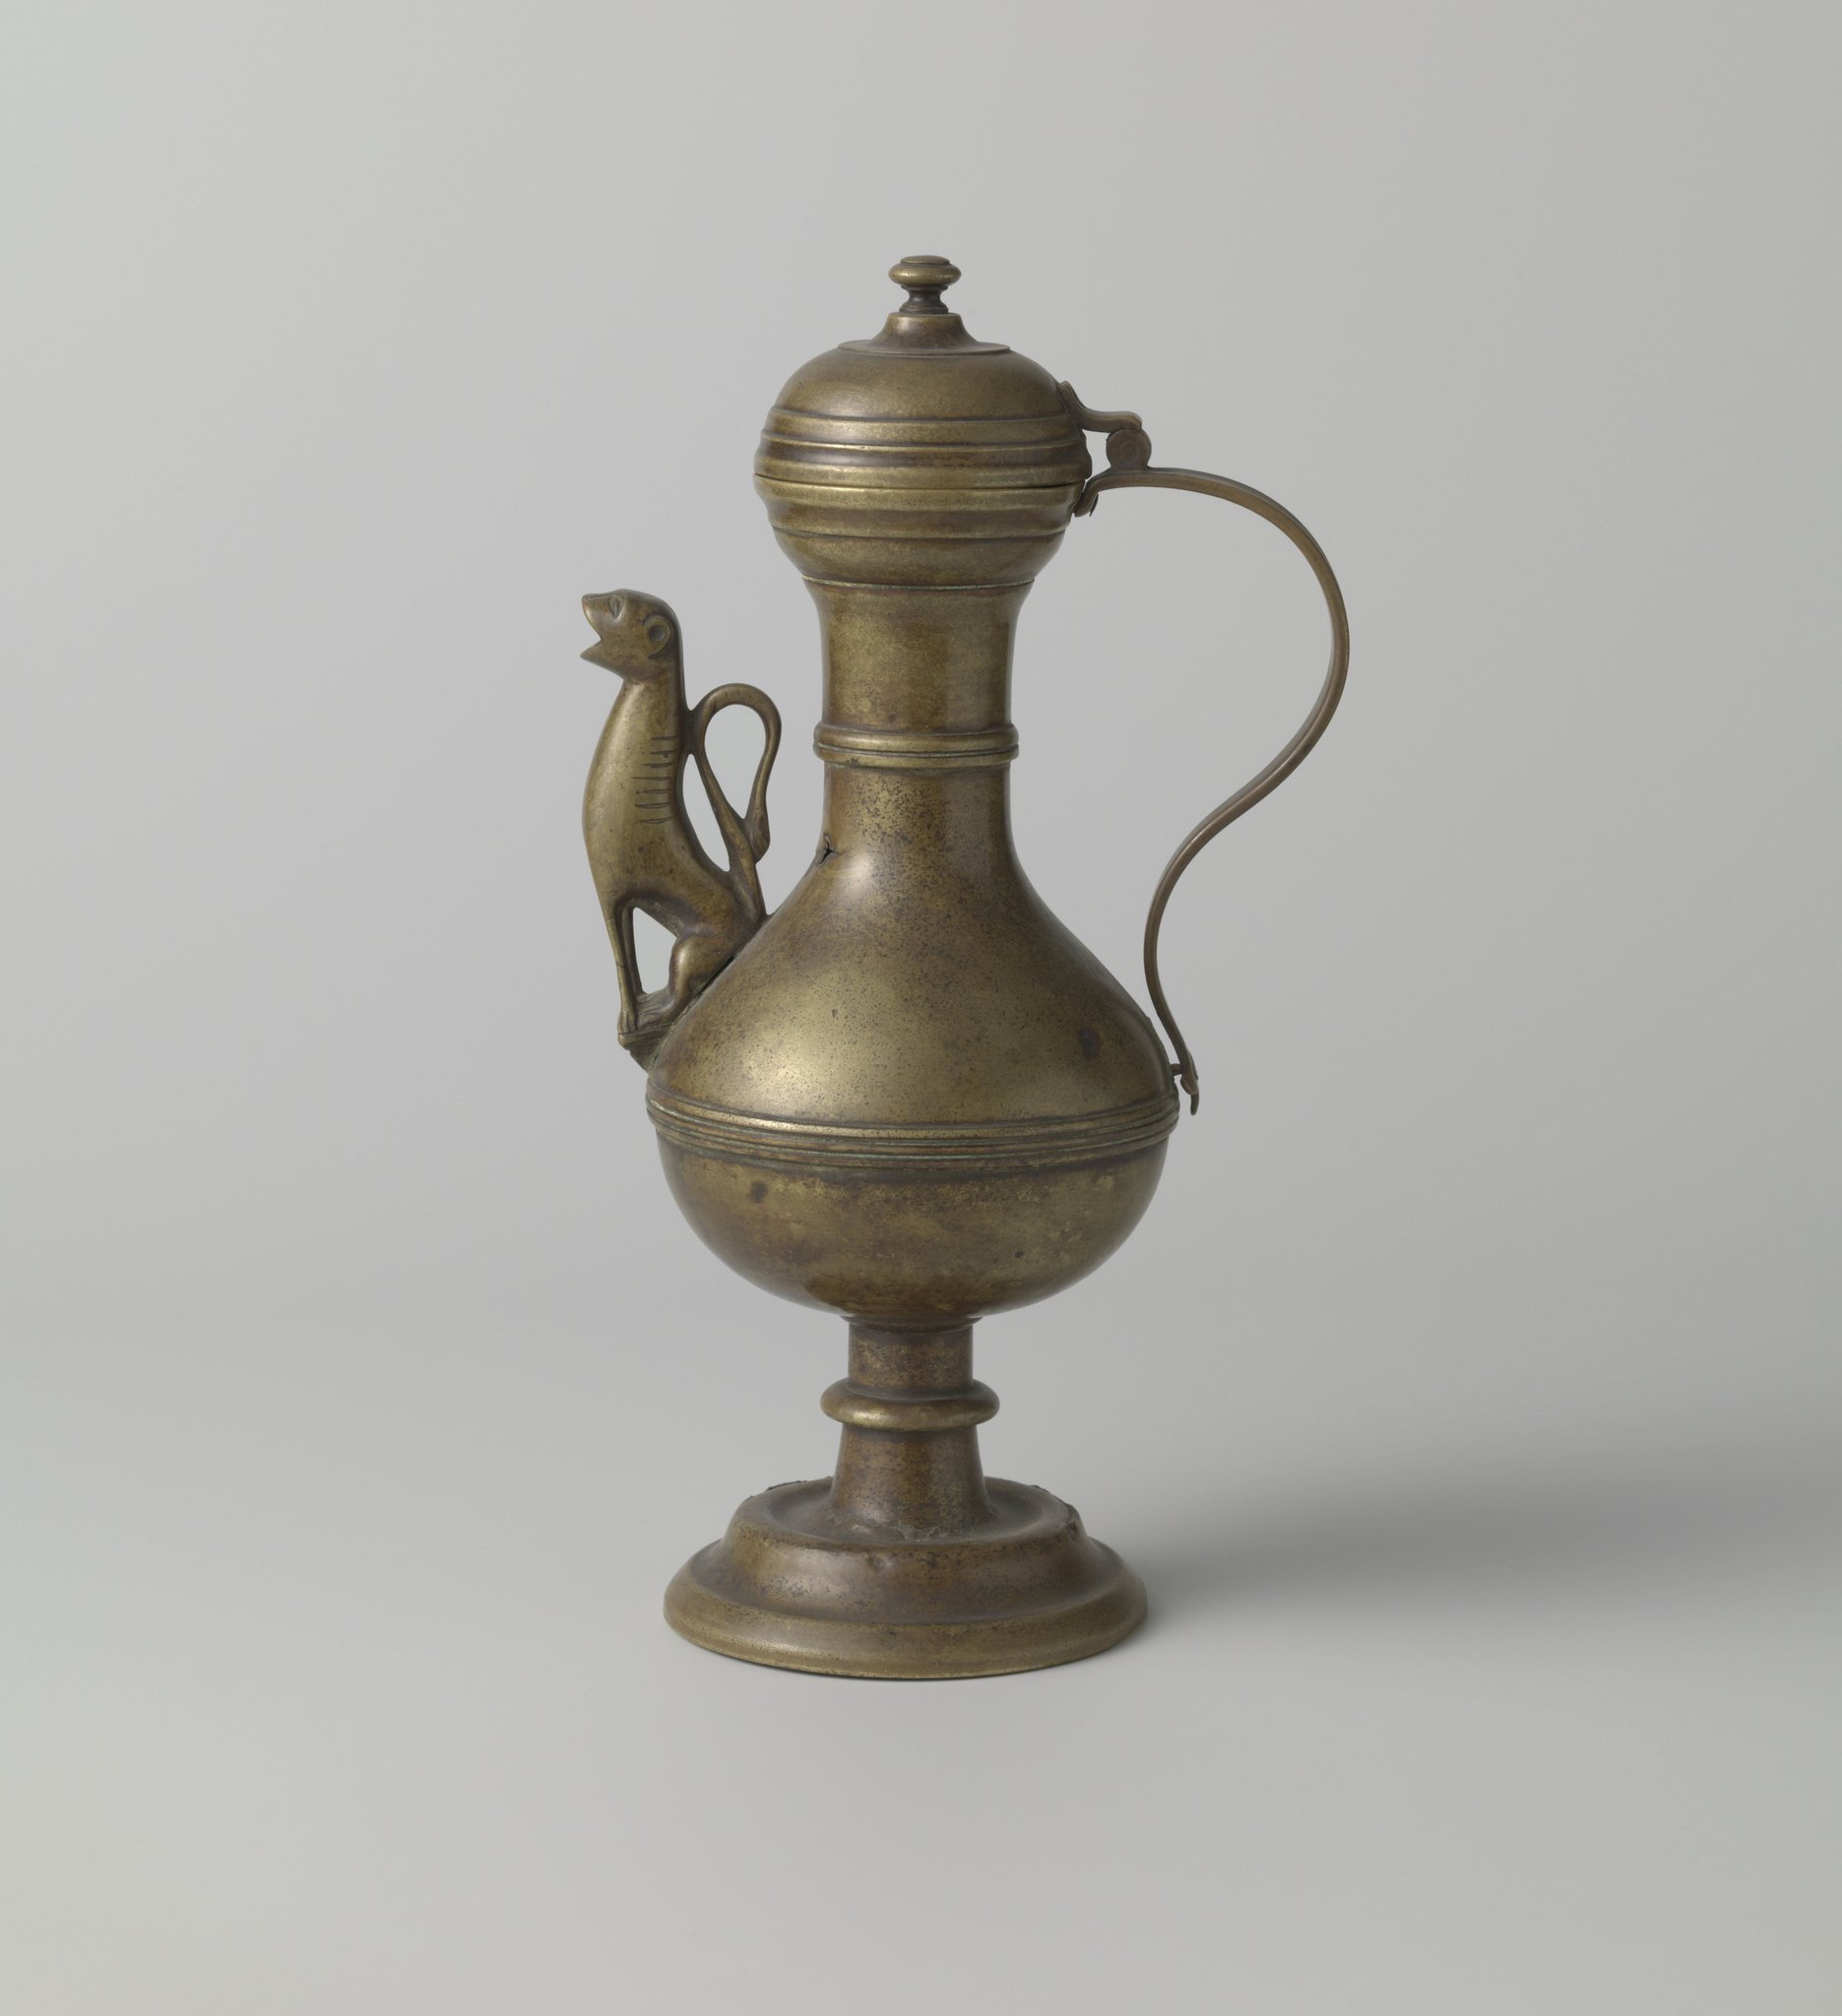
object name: ewer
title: Kan met tuit in de vorm van een leeuw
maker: Anonymous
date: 1800-1900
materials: brass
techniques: brazing, casting, metalworking, riveted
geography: western europe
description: De kan is samengesteld uit de volgende delen: de voet, de romp (in twee helften), de hals, het handvat, het scharniergedeelte, dat de duimrust vervangt, het deksel, de knop (gegoten), de tuit (gegoten en bijgeciseleerd). De ronde romp staat op een hoge ronde voet, die zich onderaan verbreedt. De romp heeft een buik met eenzelfde doorsnede als de voet, en een hoge smalle hals, welke naar boven toe iets uitkraagt. Op het bolle deksel is op het verhoogde midden een geprofileerde ronde knop aangebracht. De randen van hals en deksel zijn niet schuin geprofileerd naar binnen toe. De tuit heeft de vorm van een leeuw. Het handvat, dat naar buiten en iets naar binnen uitzwenkt, heeft bovenaan een klein eenkakig scharnier en eindigt onderaan in een drieblad. Voet, romp, hals en deksel zijn versierd met grof geprofileerde ribben. De duimrust ontbreekt. Handvat, duimrust en dekselknop zijn geklonken.